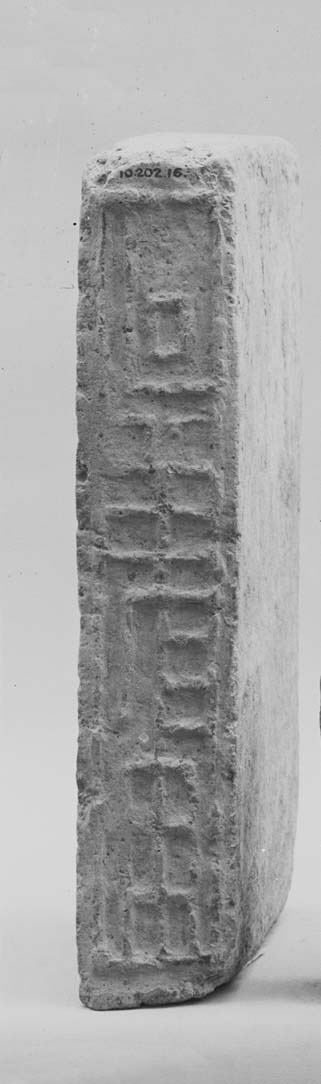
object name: tile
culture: chinese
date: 221 BCE-220 CE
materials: earthenware